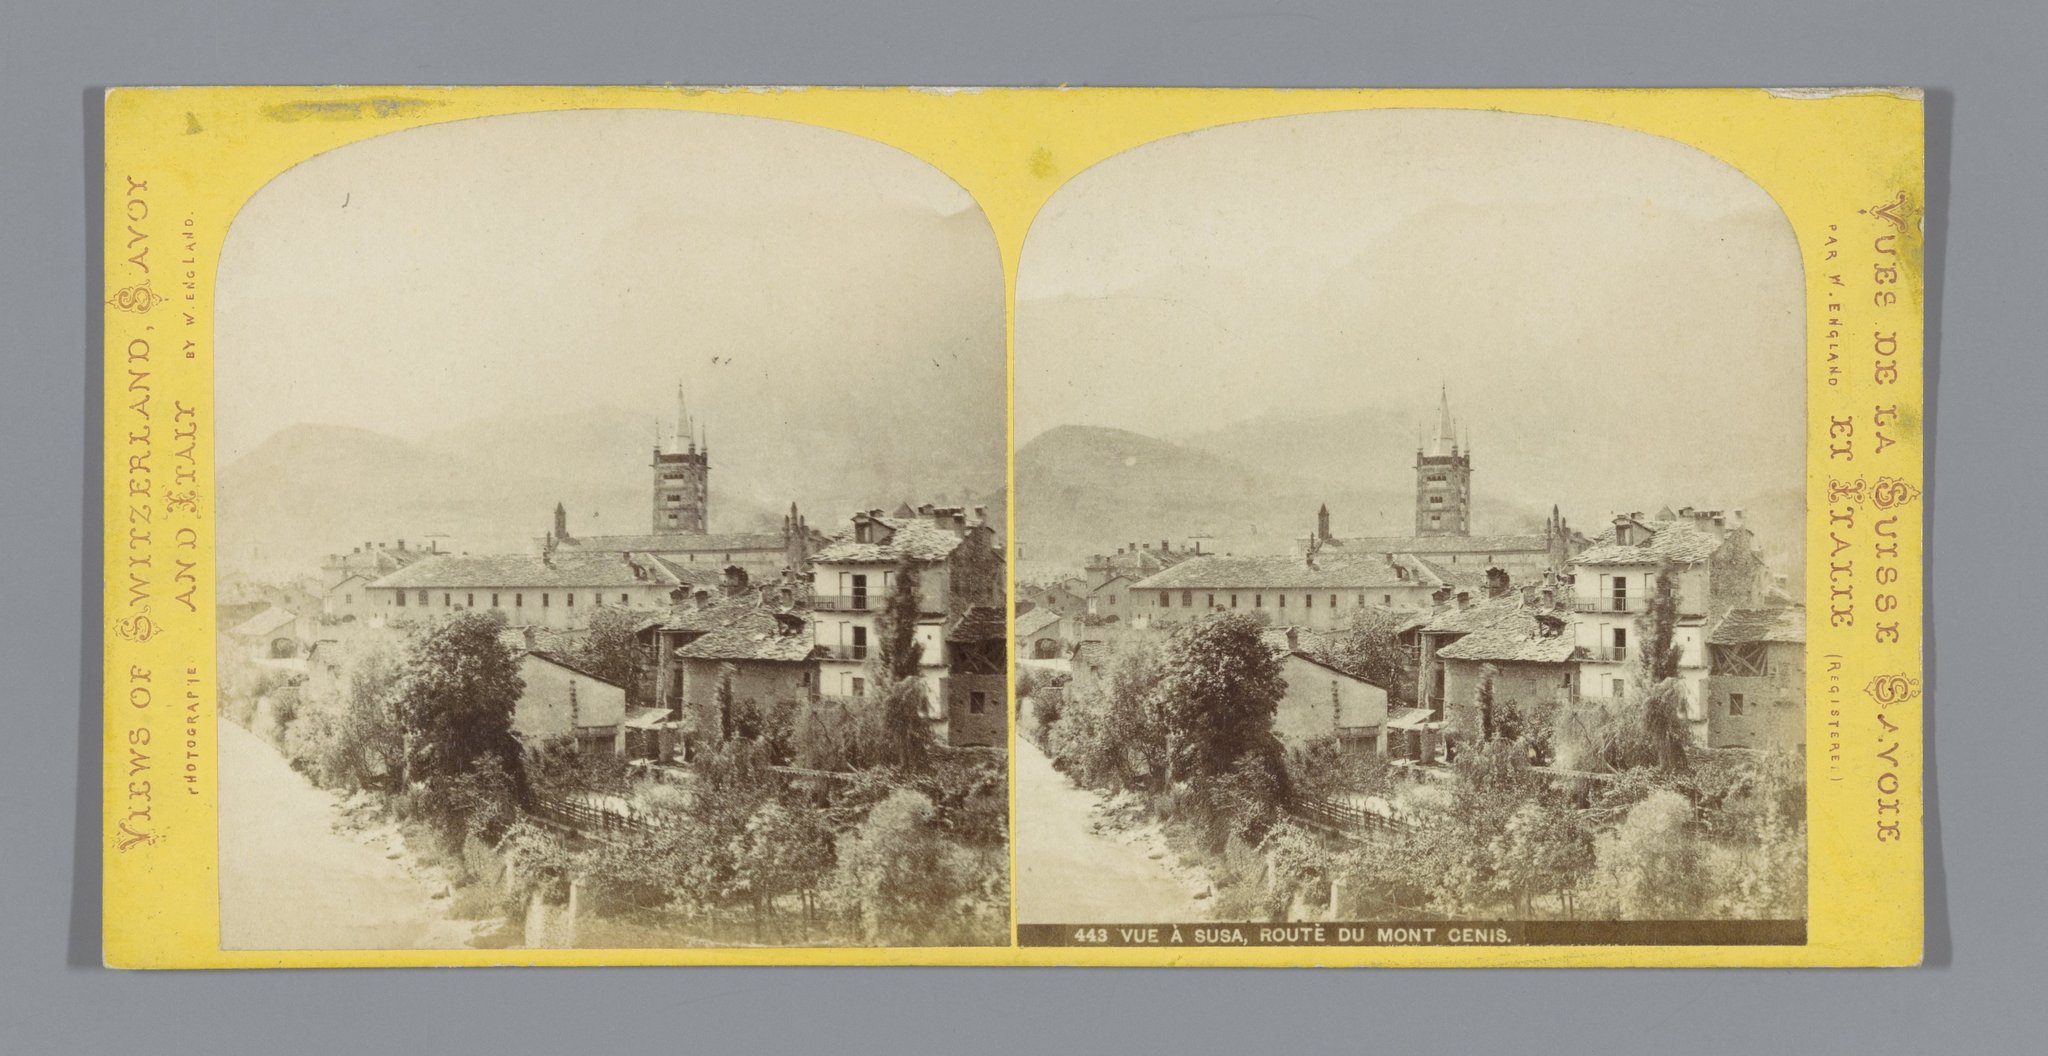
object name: stereograph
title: Vue à Susa, routè du Mont Cenis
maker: william england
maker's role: fotograaf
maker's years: 1816-1896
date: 1850-1880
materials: cardboard, photographic support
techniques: albumen print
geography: susa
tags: city-view, and landscape with man-made constructions, tower, clock tower ~ monumental adornment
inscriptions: inscription: ‘Vues de la Suisse Savoie et Italie’, number: ‘443’